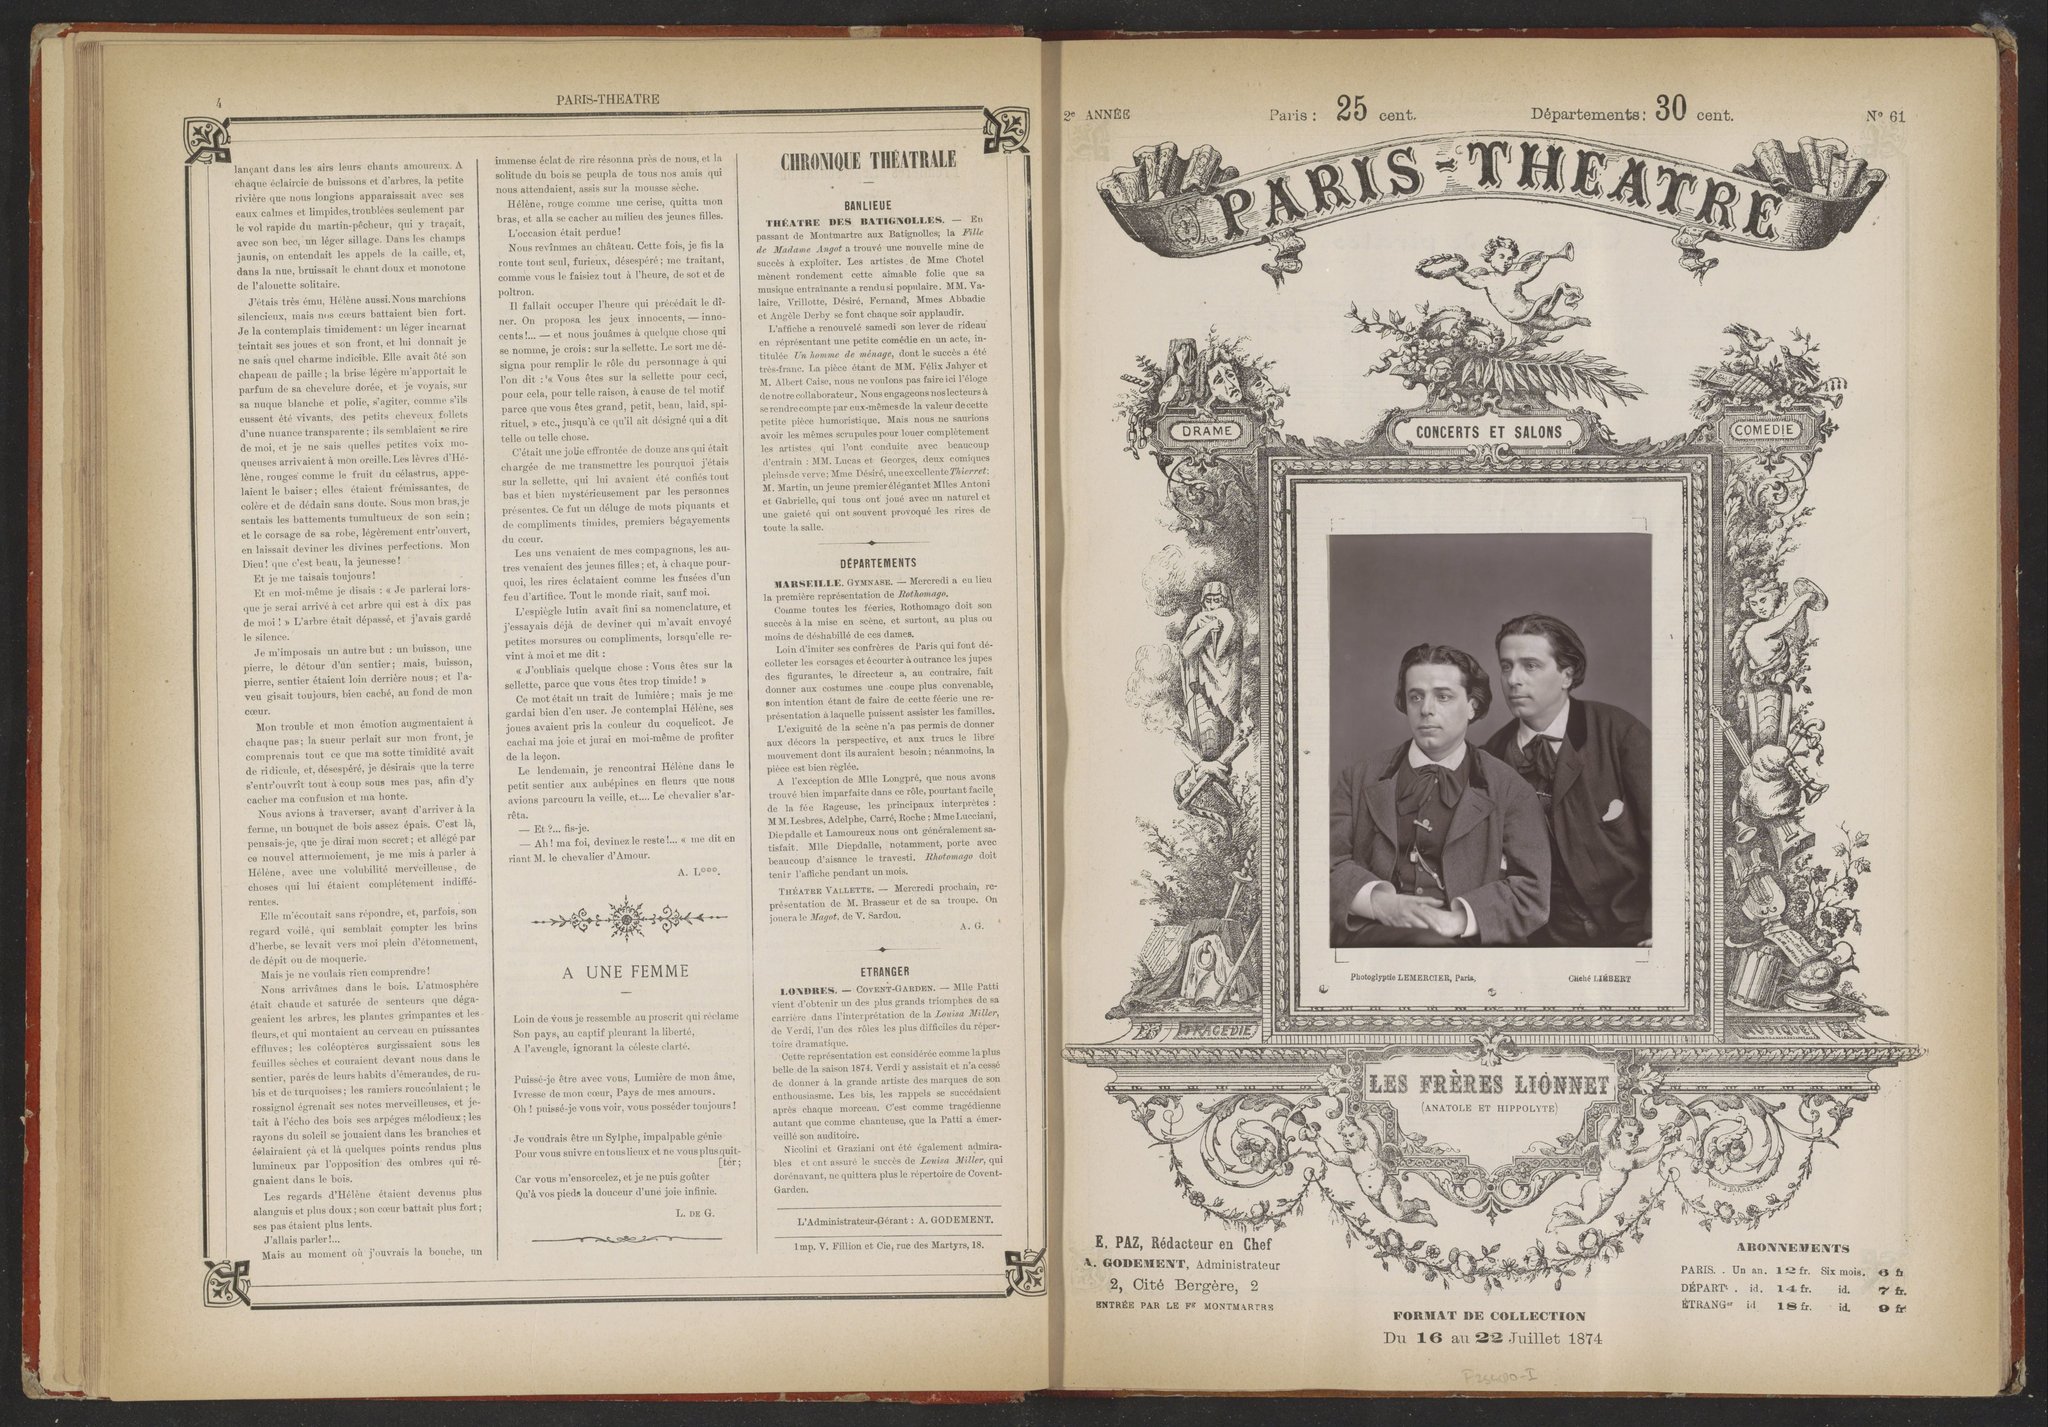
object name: page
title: Portret van de gebroeders Lionnet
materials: paper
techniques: woodburytype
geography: paris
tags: portrait of opera-singer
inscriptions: inscription: ‘Du 16 au 22 Juillet 1874’, number: ‘No 61’